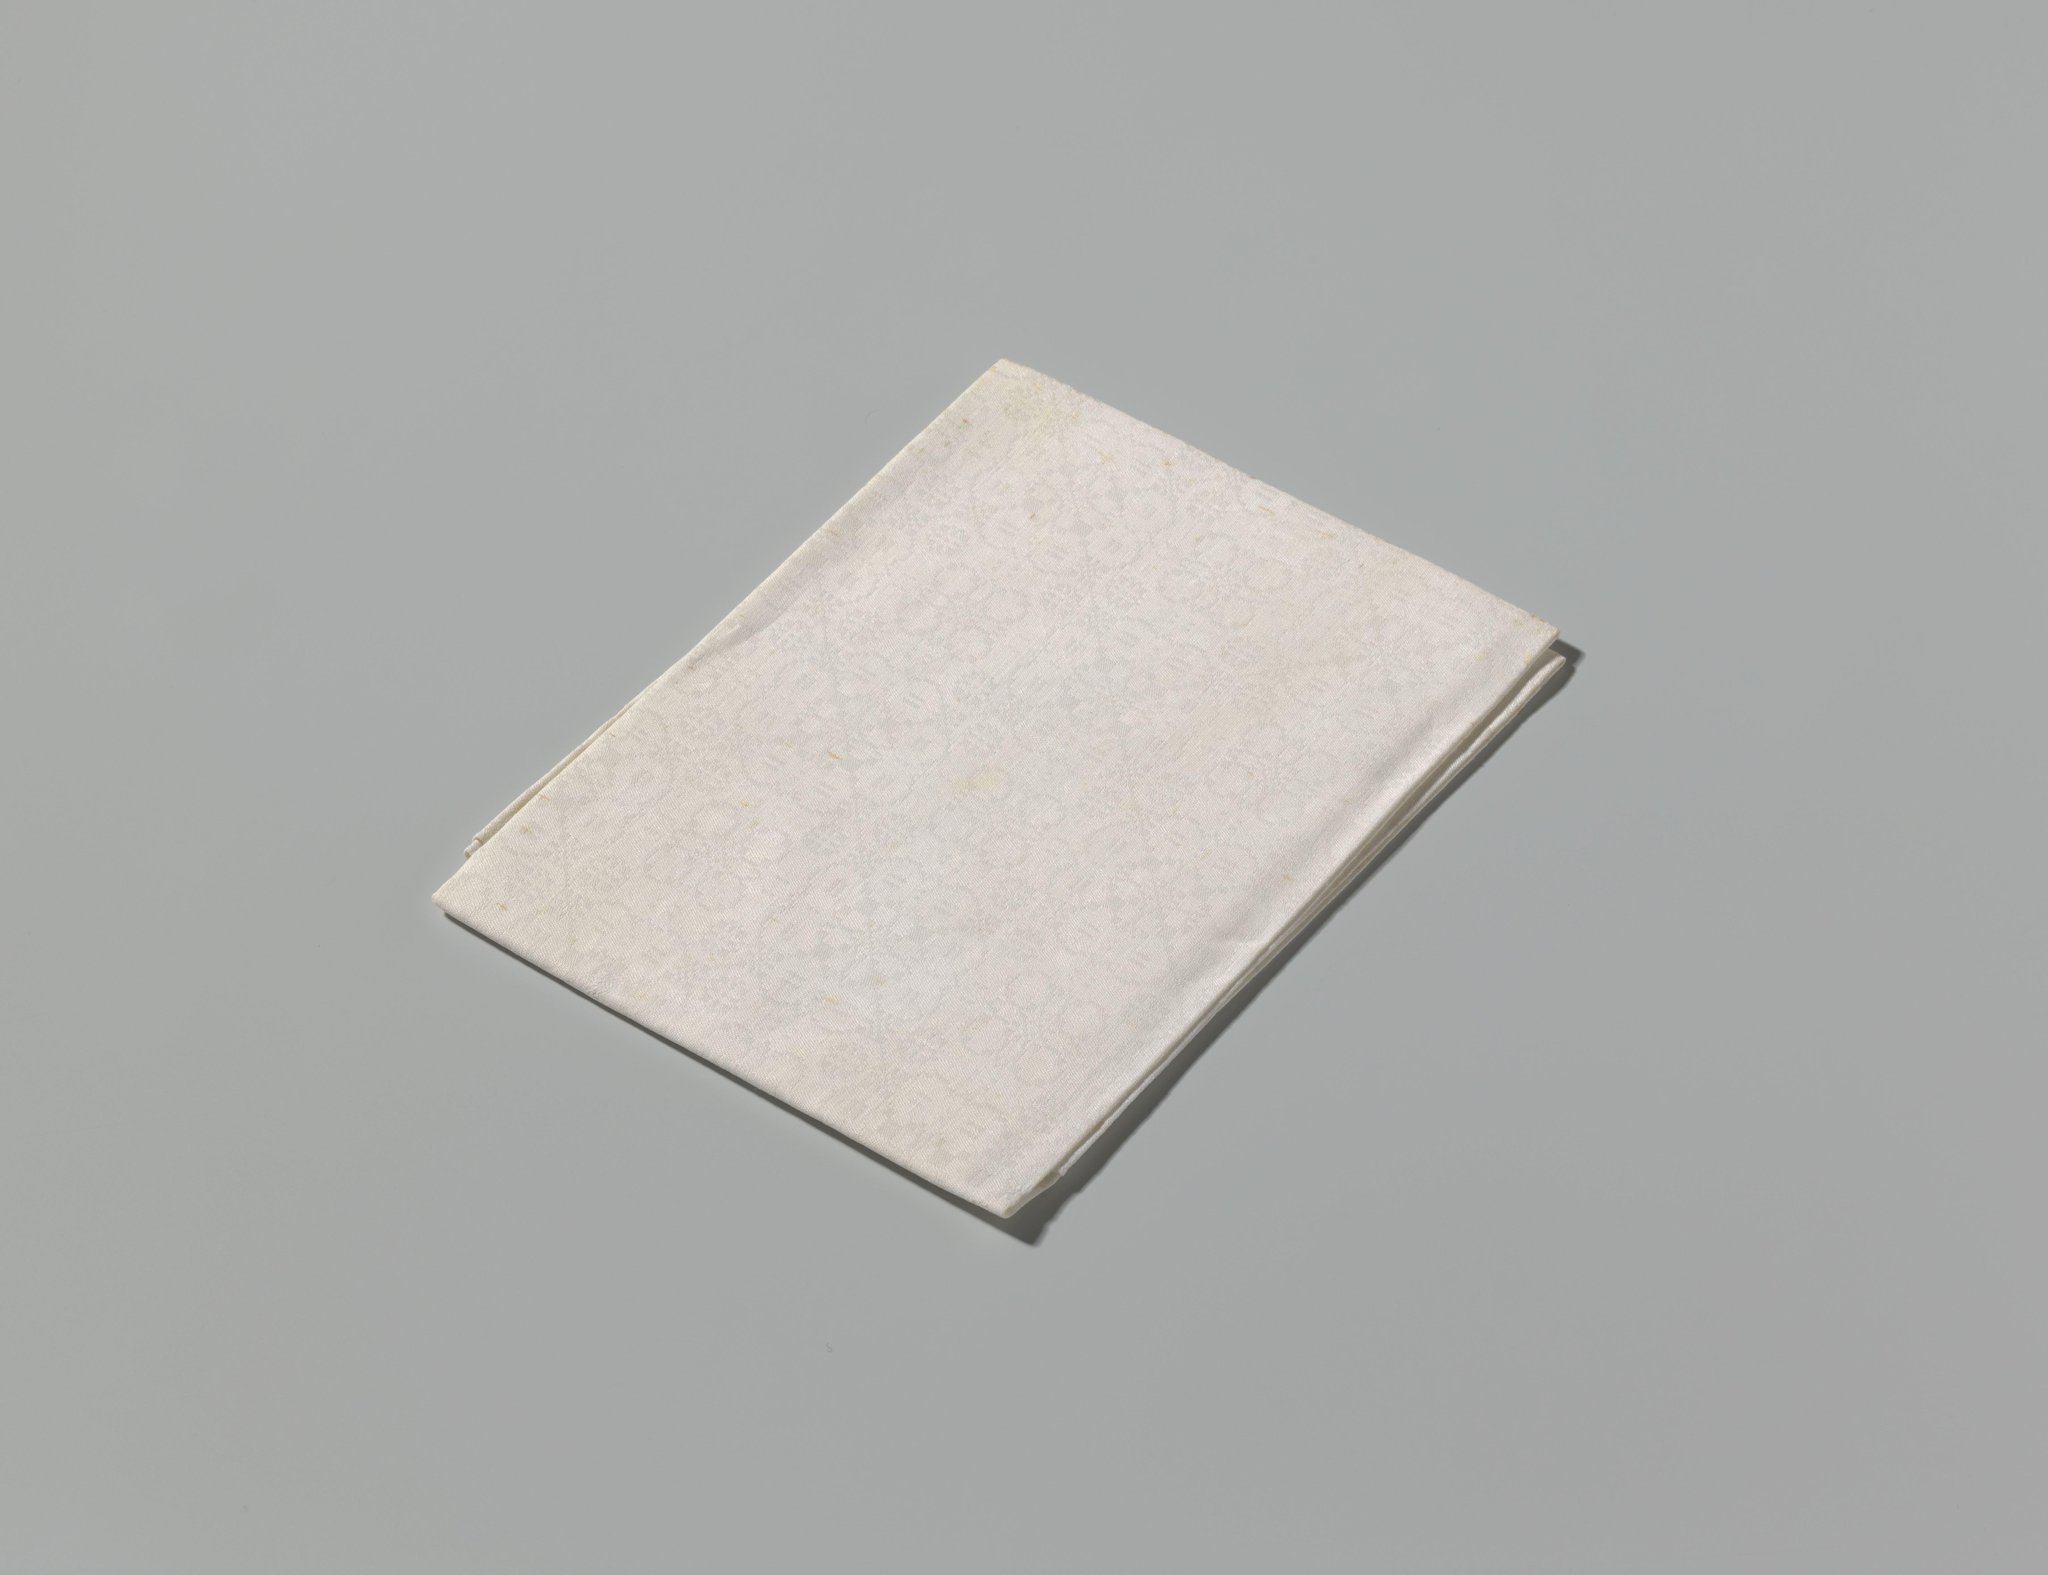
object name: napkin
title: Servet van pellendamast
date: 1700-1800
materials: linen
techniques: weave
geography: northern netherlands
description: Servet van linnen pellendamast. Het patroon heeft diagonale lijnen die elkaar kruisen met op elk kruispunt en binnen elk ontstane veld een gestileerde rozet. De lopende randen zijn niet afgewerkt. Het servet heeft een aangenaaid nummer 1193 van rood op wit.